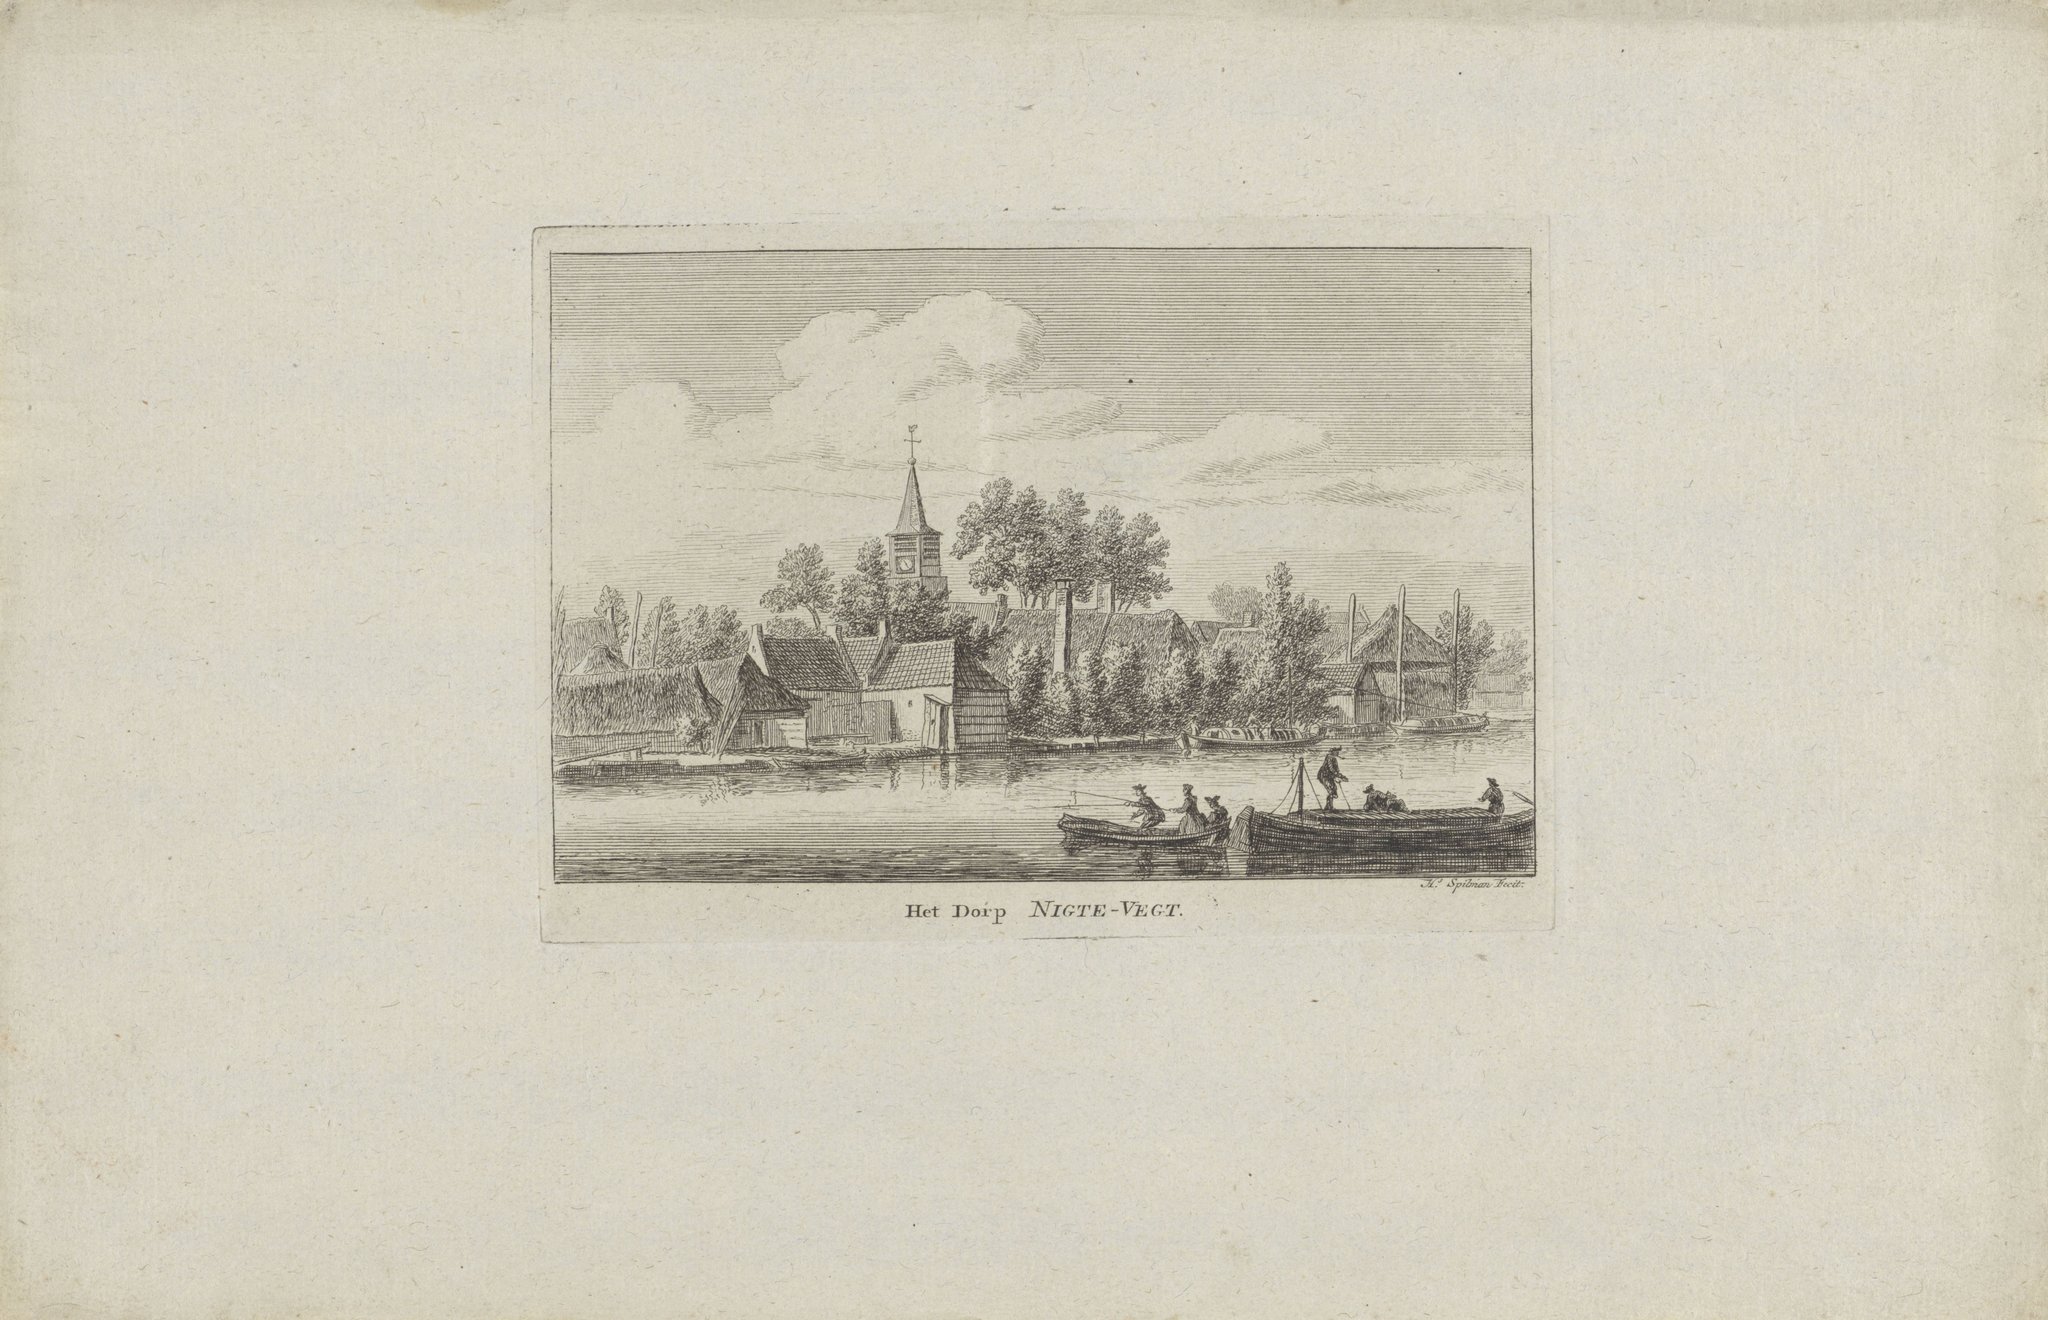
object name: print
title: Gezicht op Nigtevecht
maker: hendrik spilman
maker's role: draughtsman, painter, print maker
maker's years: 1721-1784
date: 1742-1784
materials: paper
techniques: etching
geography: haarlem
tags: river, church (exterior), angling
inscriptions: collector's mark: Lugt 2228